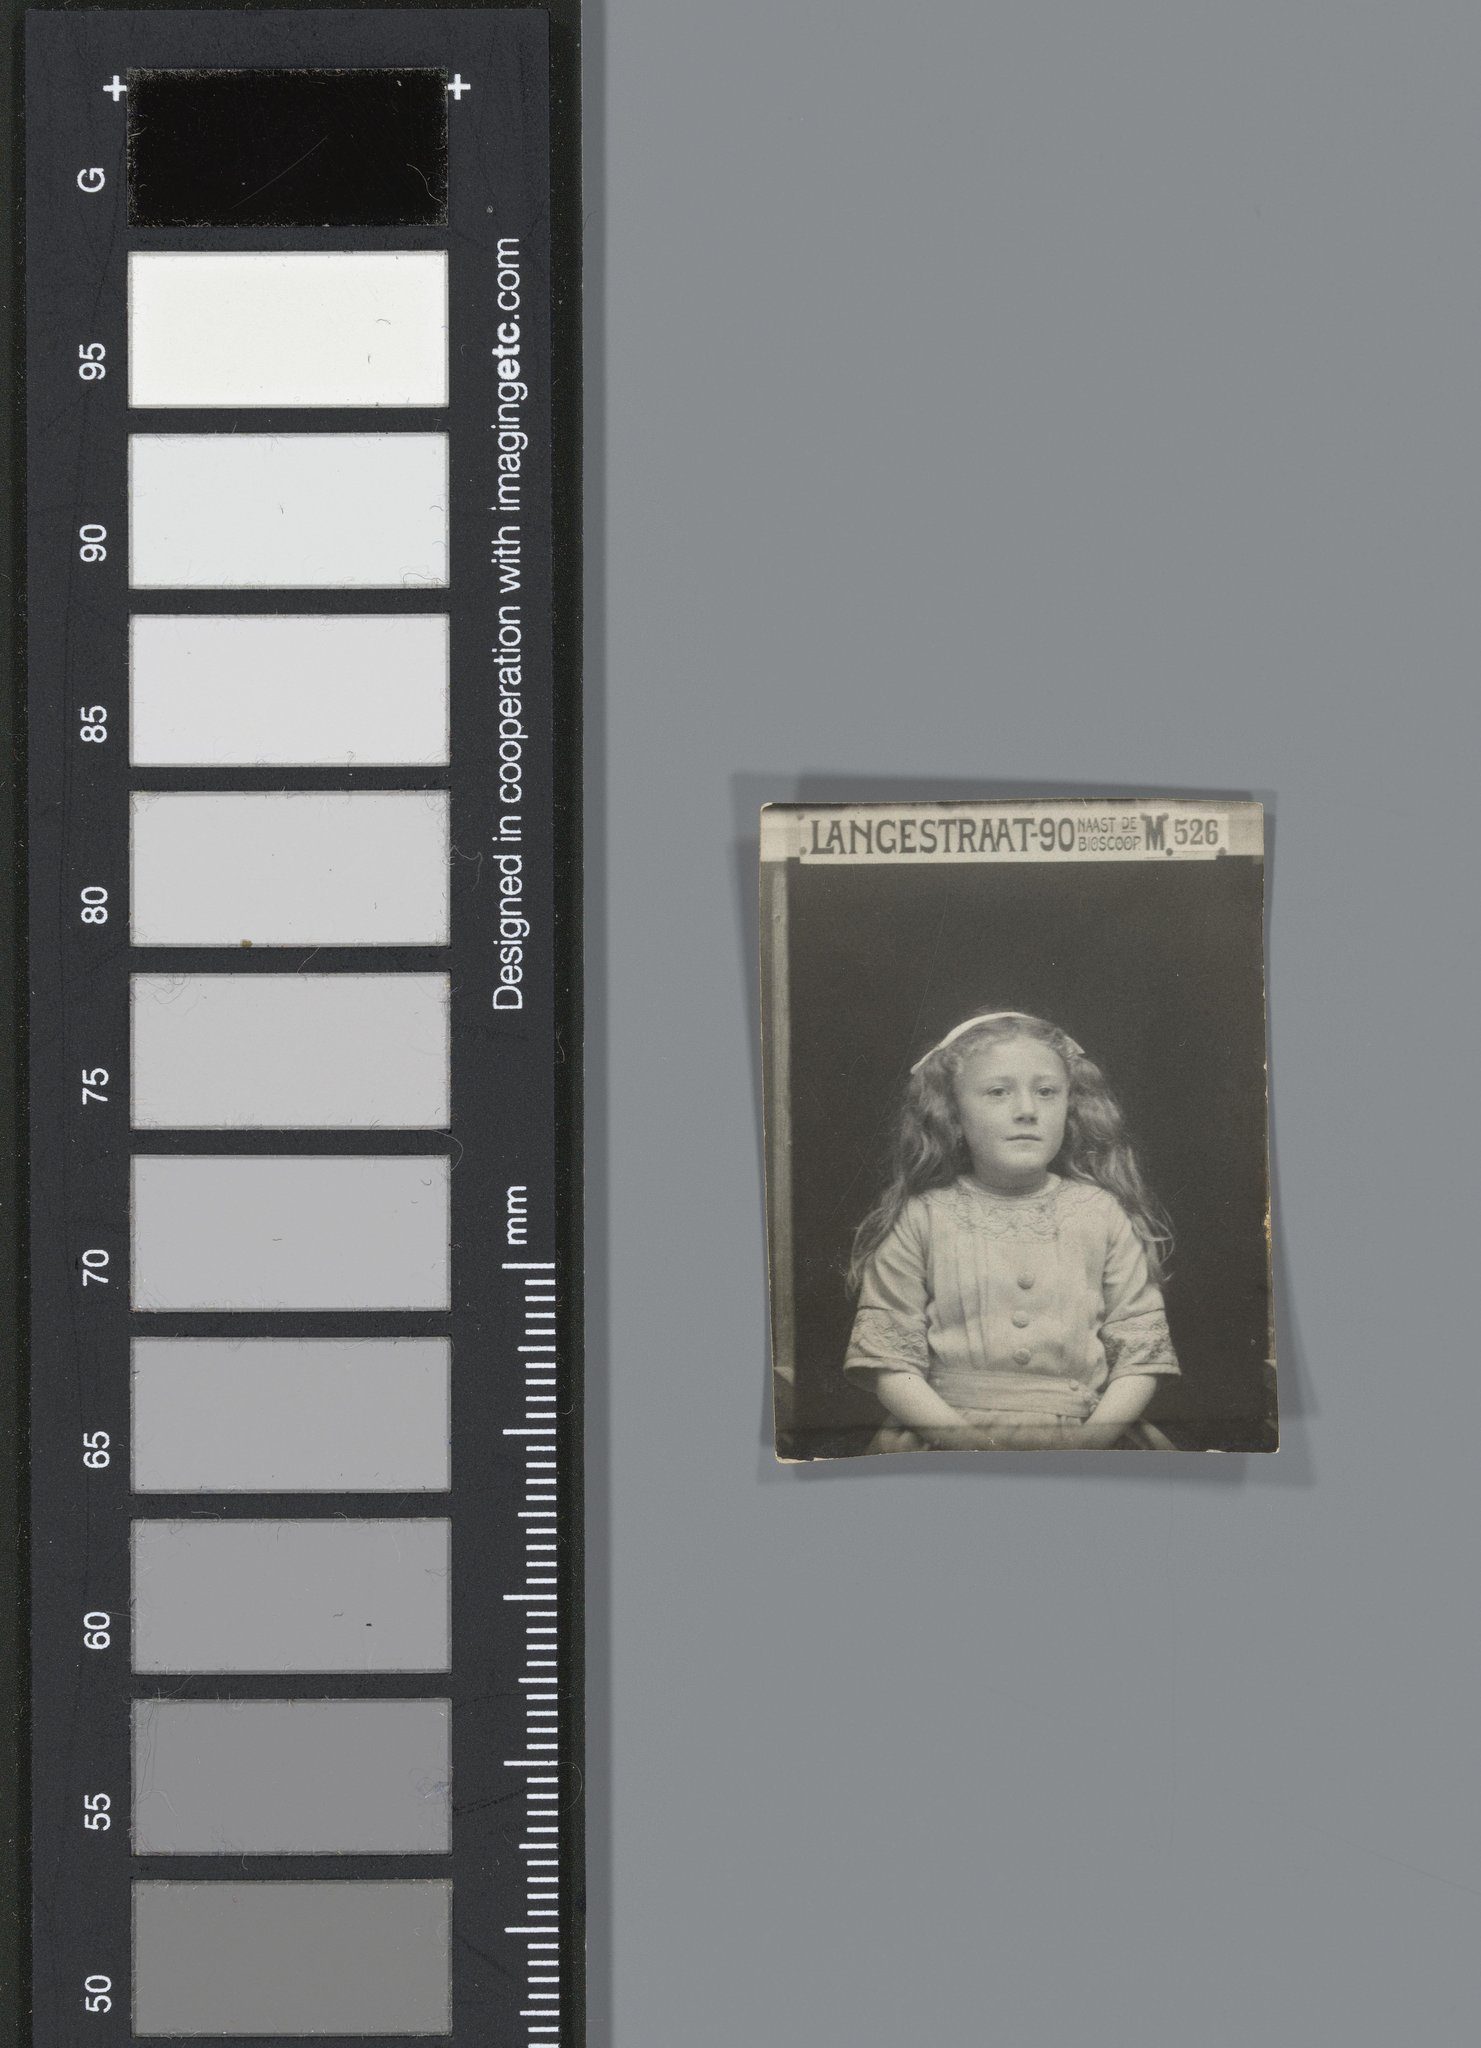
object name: snapshot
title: Rapid photographs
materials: photographic support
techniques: gelatin silver print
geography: alkmaar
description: Between 1912 and 1930, anyone could have their portrait taken at the many so-called rapid photography studios in the shopping streets of mainly (medium) large-size European cities. As if on an assembly line, the youngest clerk shot the photographs with a special camera and in artificial light and developed them. Later in the day, the customer collected a sheet with 12 portrait photos for 25 cents. This form of photographic mass production gave rise to a fascinating tableau of boys, girls, men and women not previously seen in photographs; candid and informal. There were at least 150 quick-photo studios, from Alkmaar to Zutphen. Many called themselves ‘American,’ mistakenly as it turns out because hardly any examples from that country have been found.